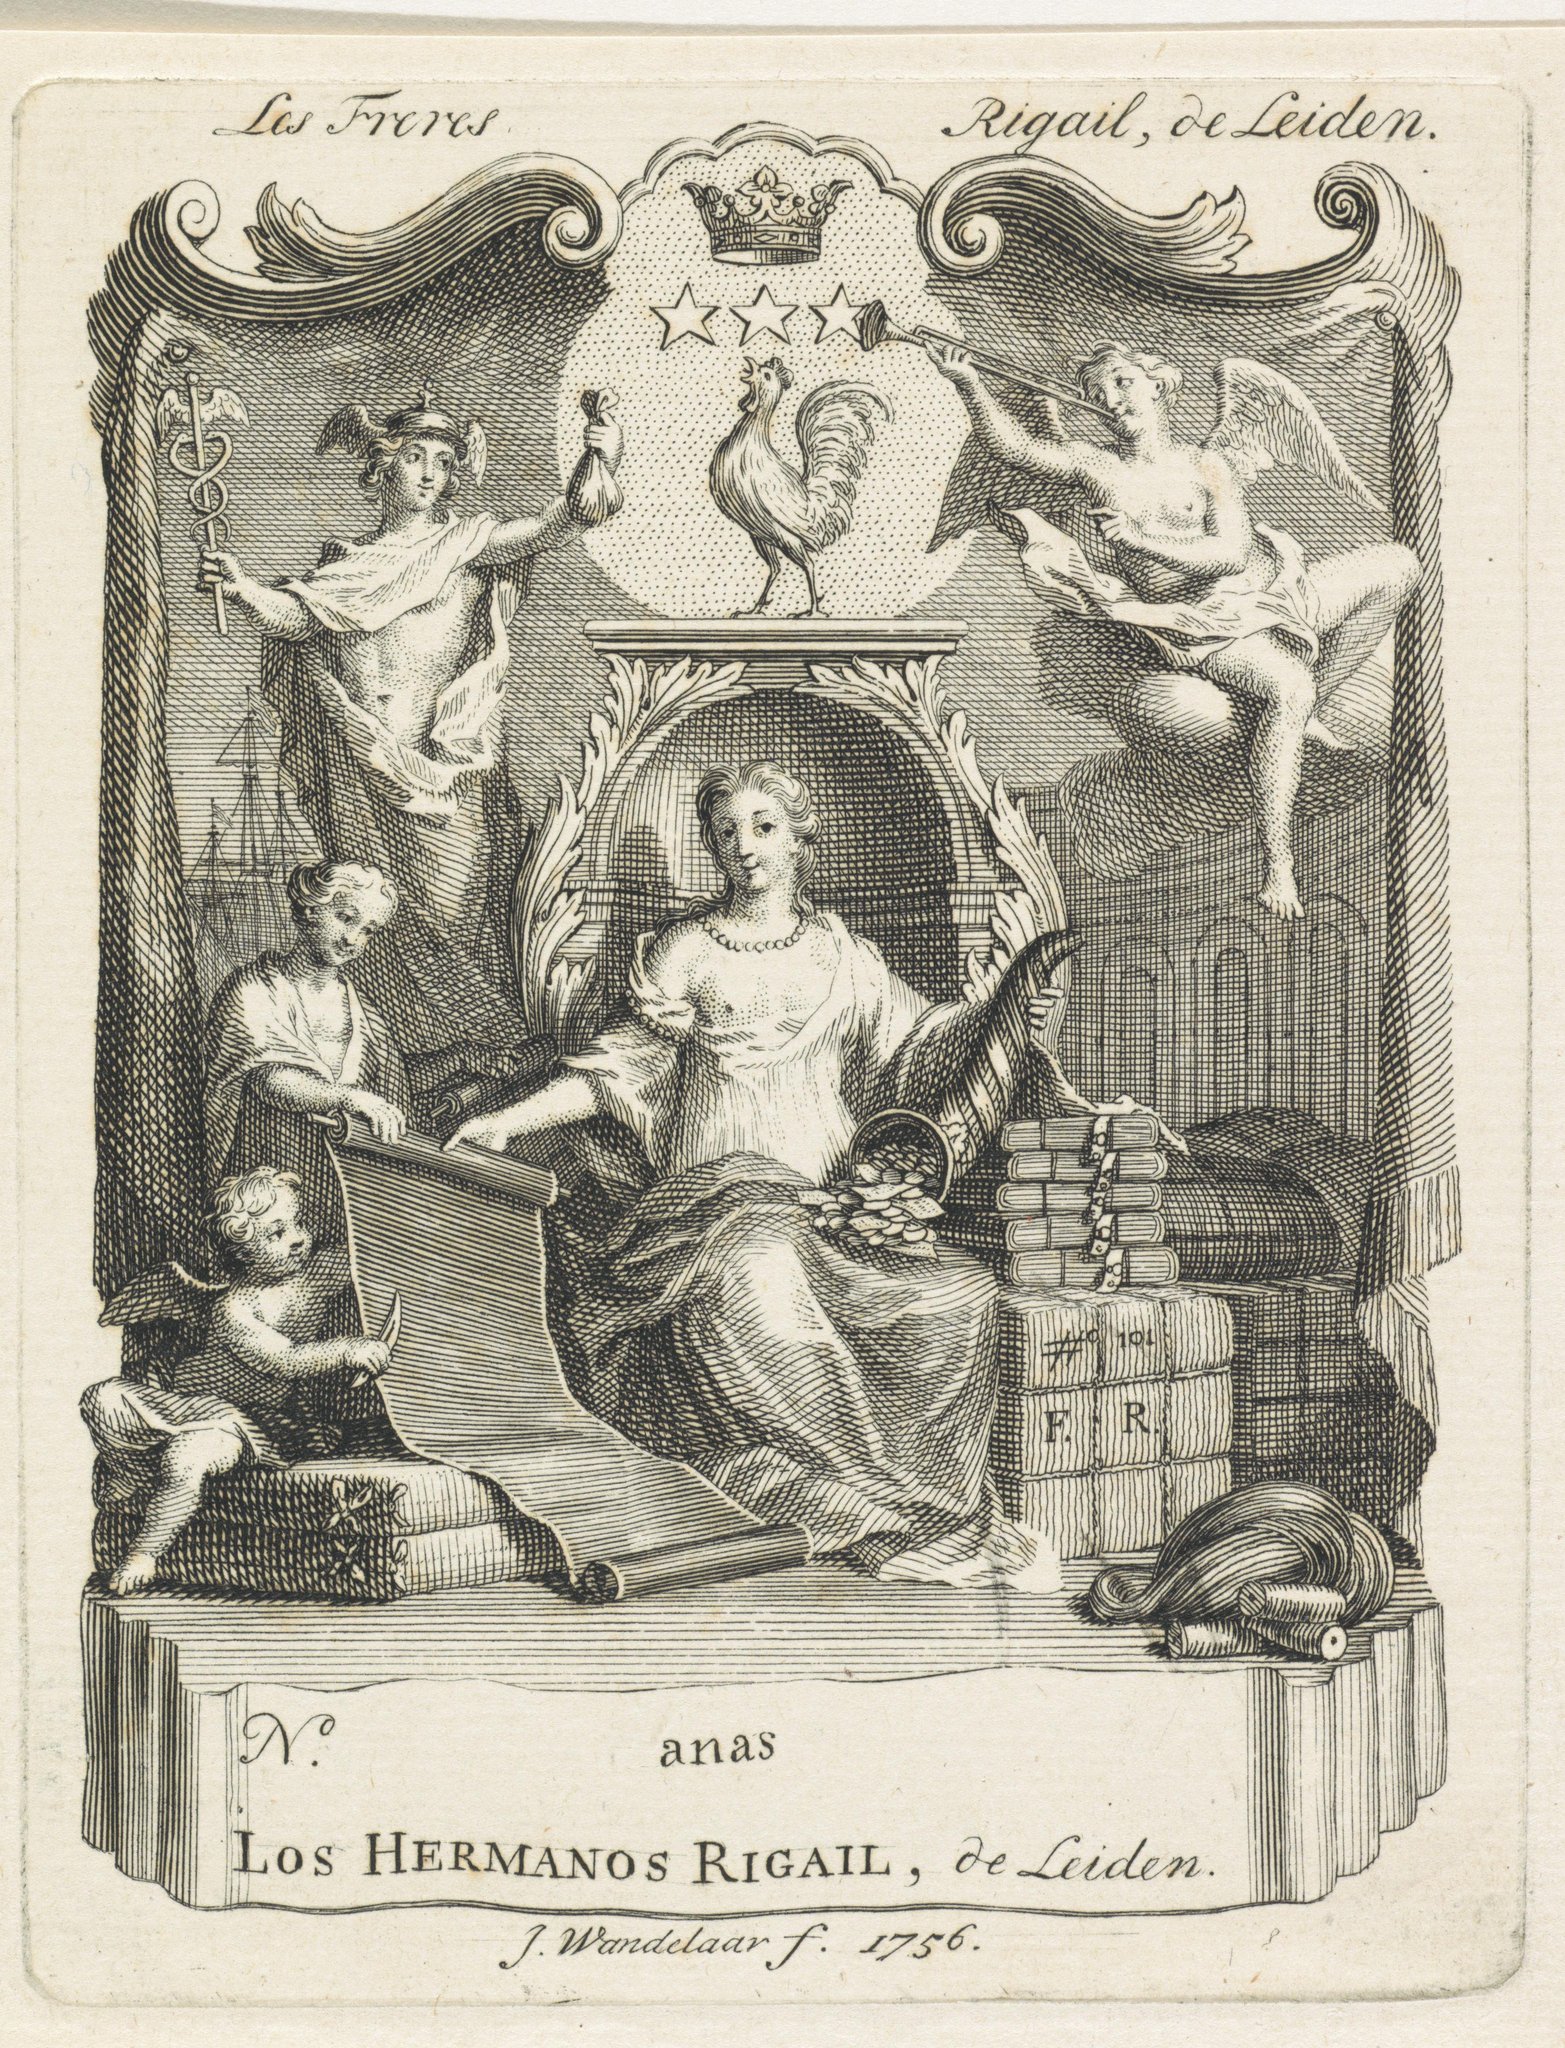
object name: print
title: Handelsetiket van zijdefabrikeurs Rigail te Leiden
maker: jan wandelaar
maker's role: draughtsman, print maker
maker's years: 1690-1759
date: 1756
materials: paper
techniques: engraving, etching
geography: leiden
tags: trade-company, fama as roman personification, specific aspects, allegorical aspects of mercury; mercury as patron, silk (material ~ textile industry), leiden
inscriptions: collector's mark: Lugt 240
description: In het midden zit een vrouw met een ontblote borst en een parelketting, mogelijk Fortuna. In haar linkerhand heeft ze een hoorn des overvloeds gevuld met geld. Met haar rechterhand houdt ze een rol stof omhoog. Naast de rol zit een putto. Rechts staan verpakte goederen. Op één van de verpakkingen staat '#o 101' en het monogram F.R., waarschijnlijk François Rigail, een Leidse fabrikeur van zijde. Voor de goederen liggen spoelen en garen. Linksachter staat Mercurius met een geldbuidel bij een scheepsmodel. In het midden een wapen, bestaande uit een haan, drie sterren en een kroon. Rechts zweeft Faam op een wolk. Rond de voorstelling een ornamentele omlijsting met de naam van de broers Rigail in het Frans en onder hun naam in het Spaans op een banderol.